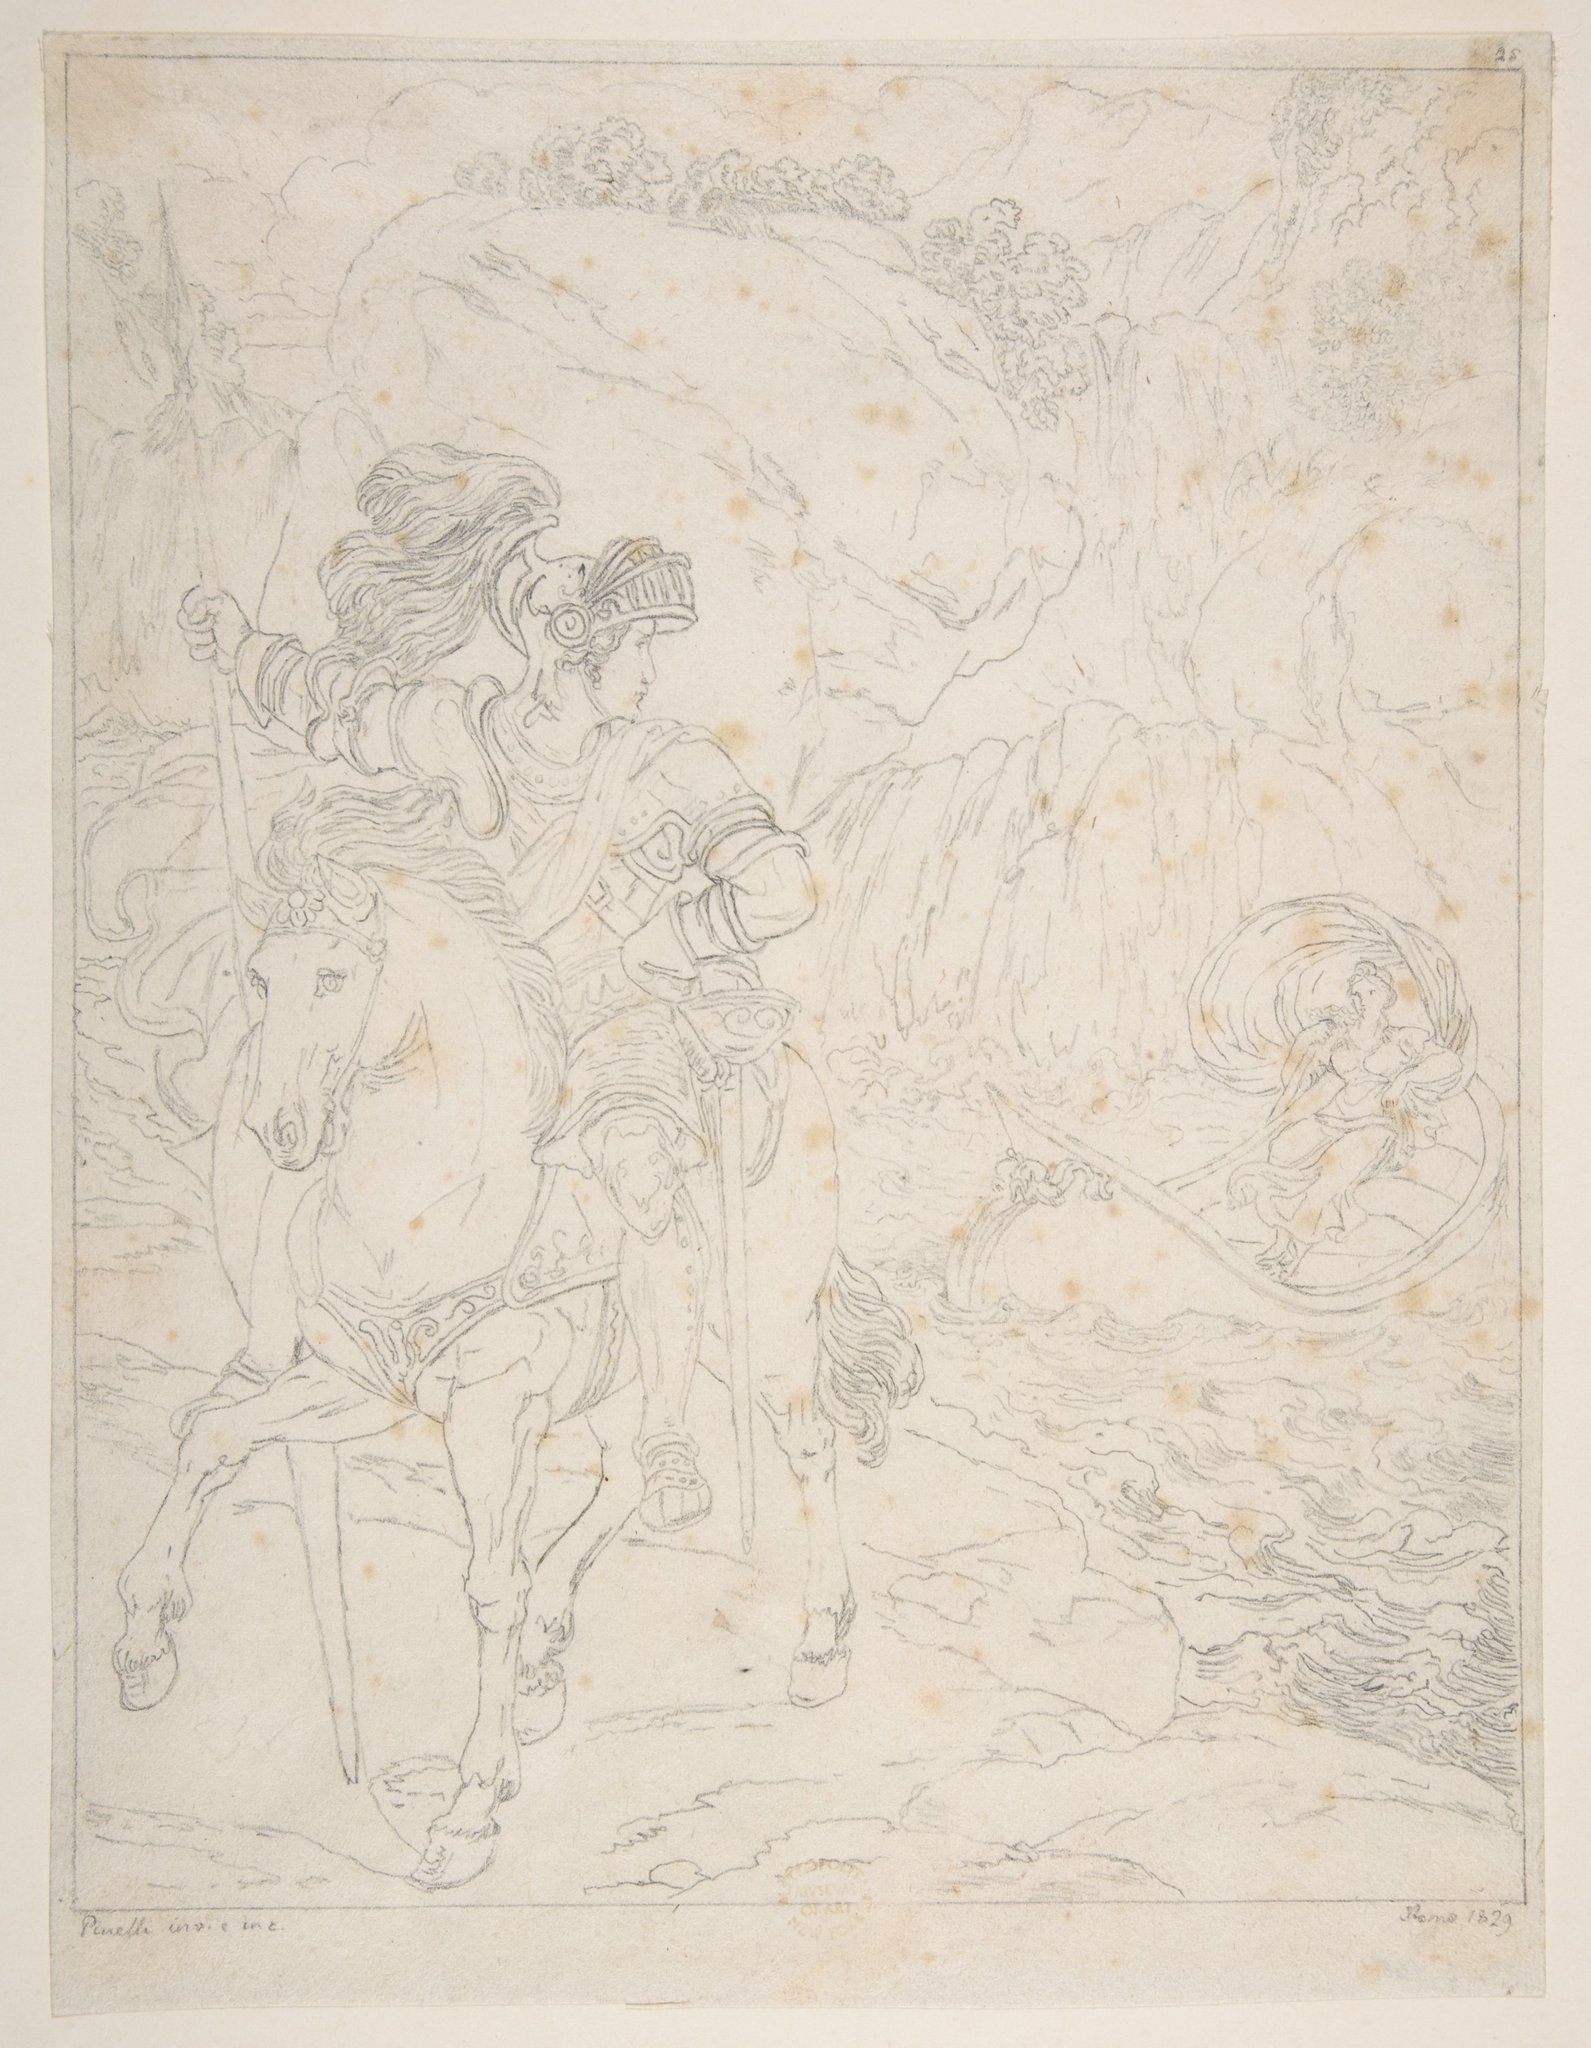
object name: drawing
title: Romantic Subject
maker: bartolomeo pinelli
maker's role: artist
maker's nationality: italian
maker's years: 1781-1835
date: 1829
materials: graphite, lead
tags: men,women,horses,boats